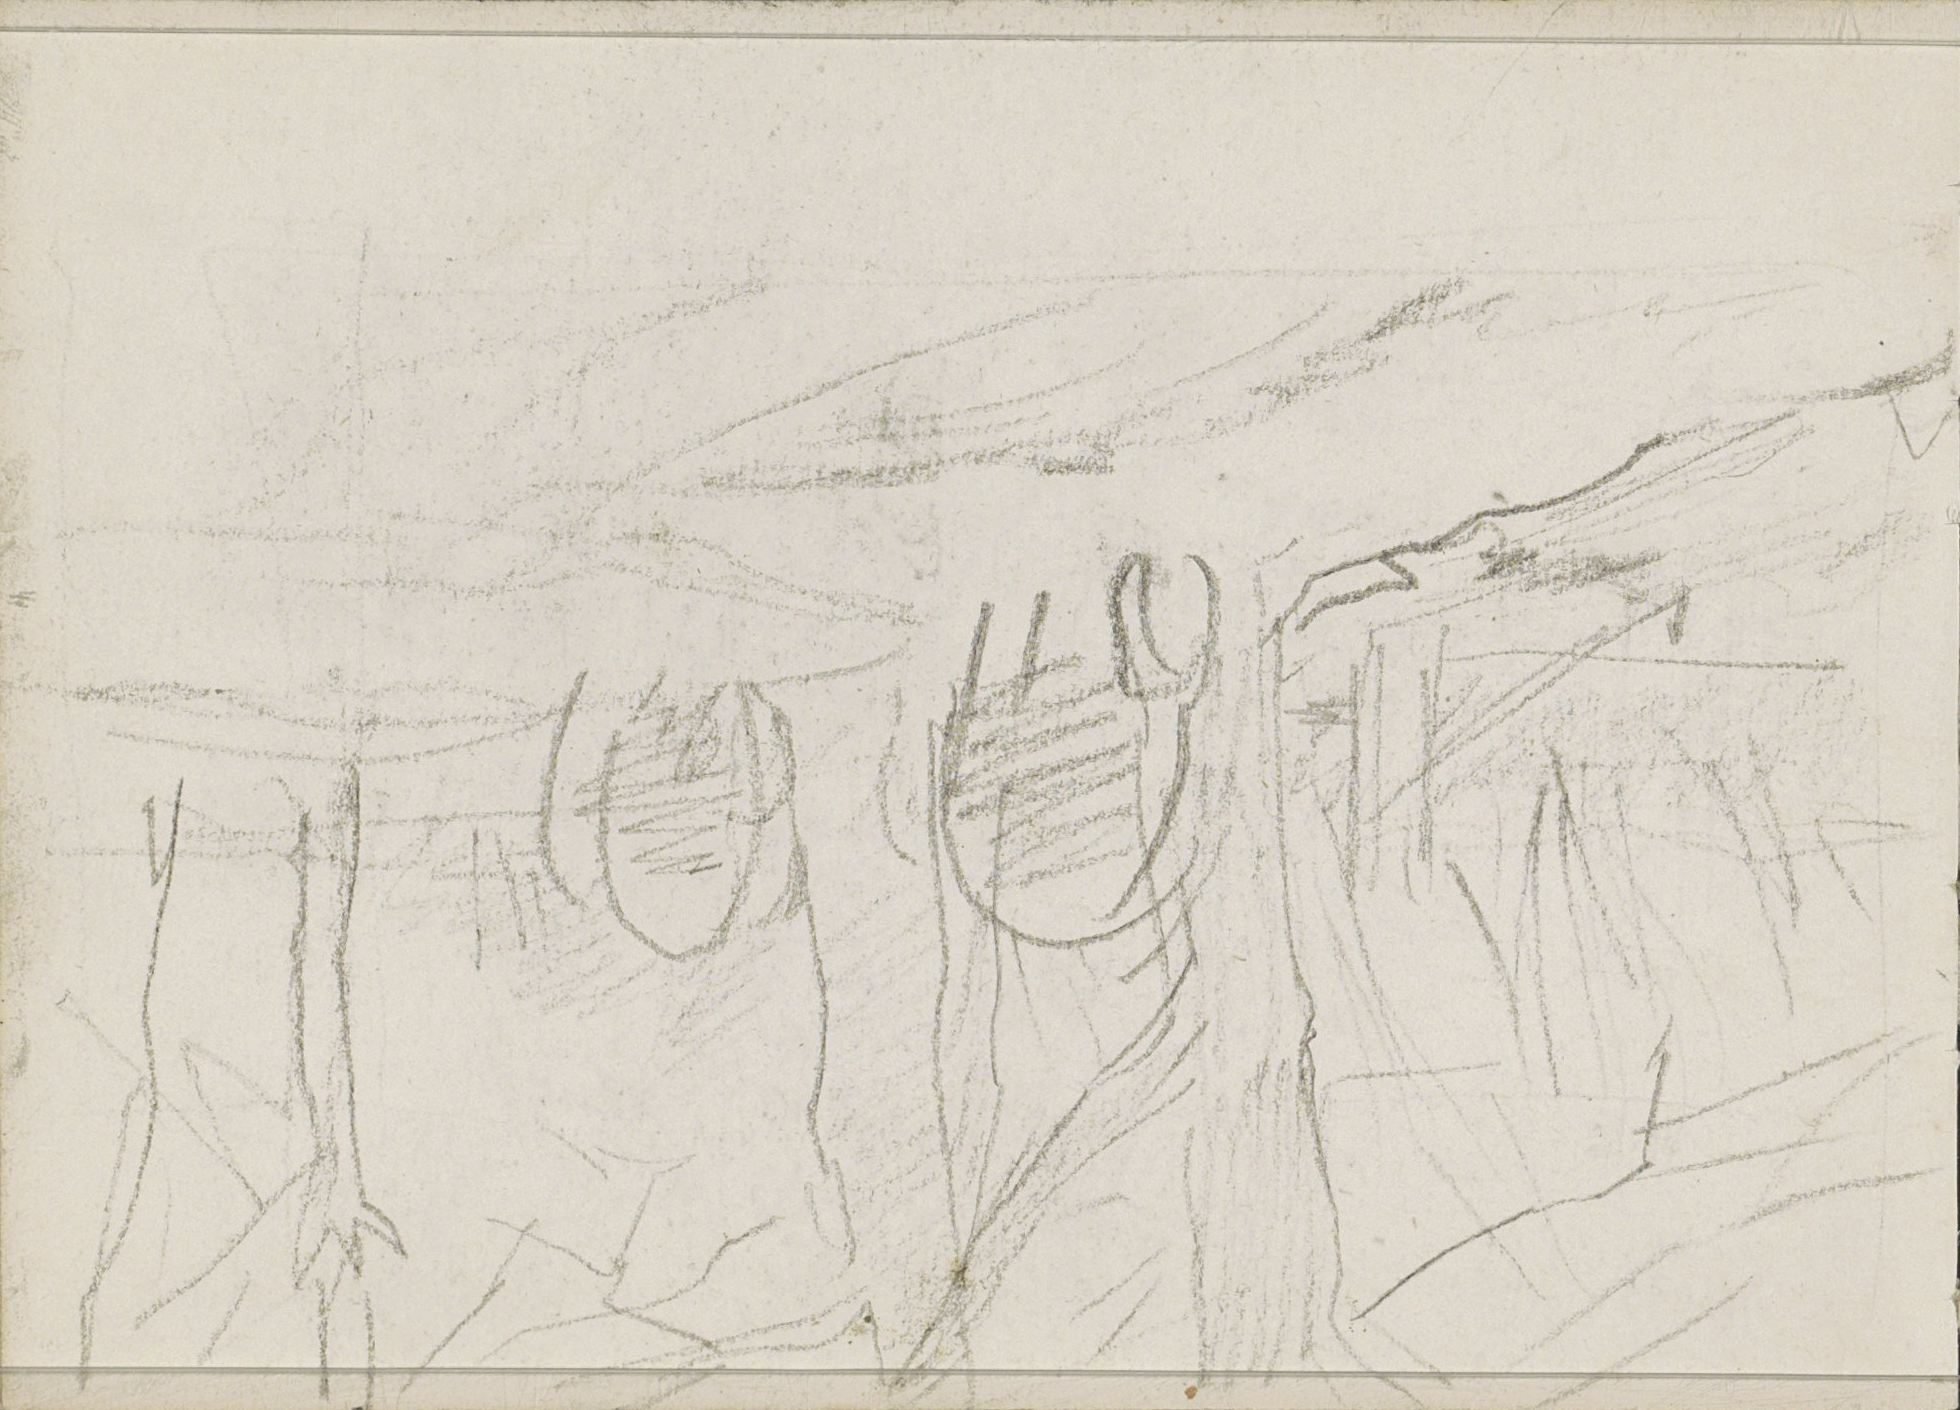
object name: sketchbook leaf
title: Landschap met bomen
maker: anton mauve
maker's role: draughtsman, painter, print maker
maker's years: 1838-1888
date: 1848-1888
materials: chalk, paper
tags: landscapes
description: Blad 14 verso uit een schetsboek met 31 bladen.